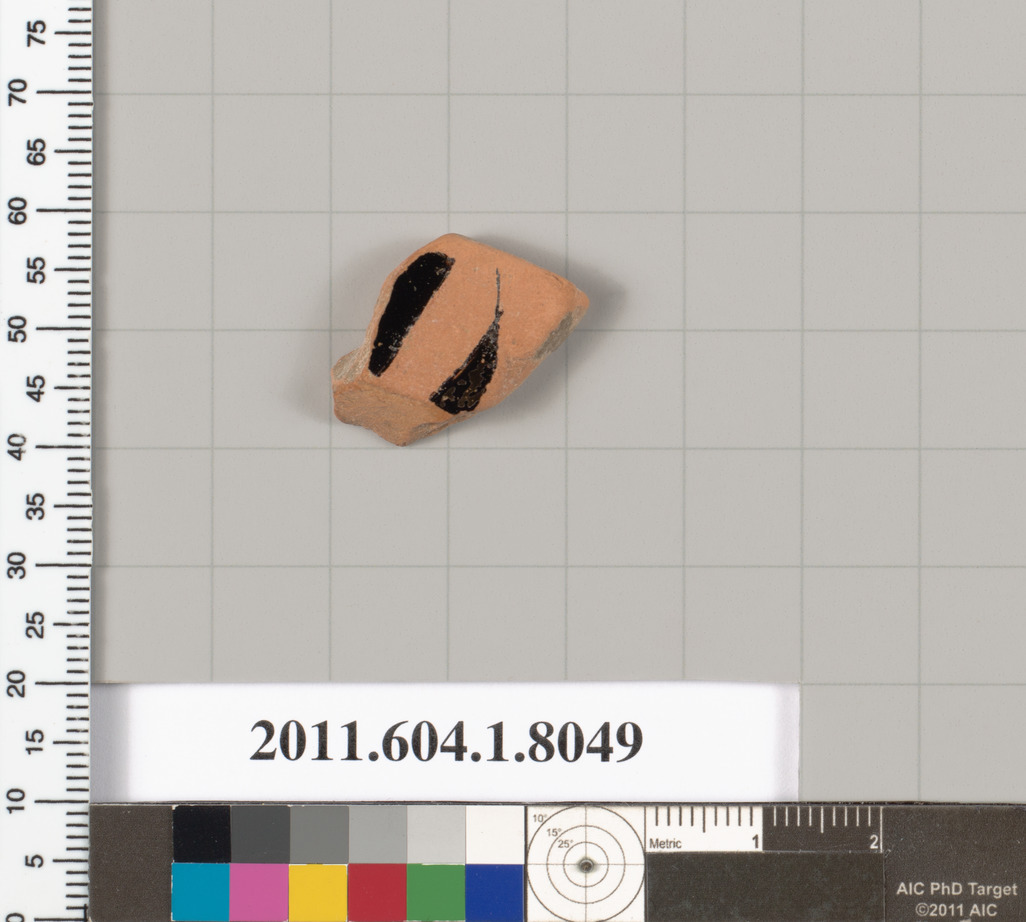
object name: kylix fragment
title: Terracotta fragment of a kylix (drinking cup)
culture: greek, attic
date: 510-490 BCE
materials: terracotta